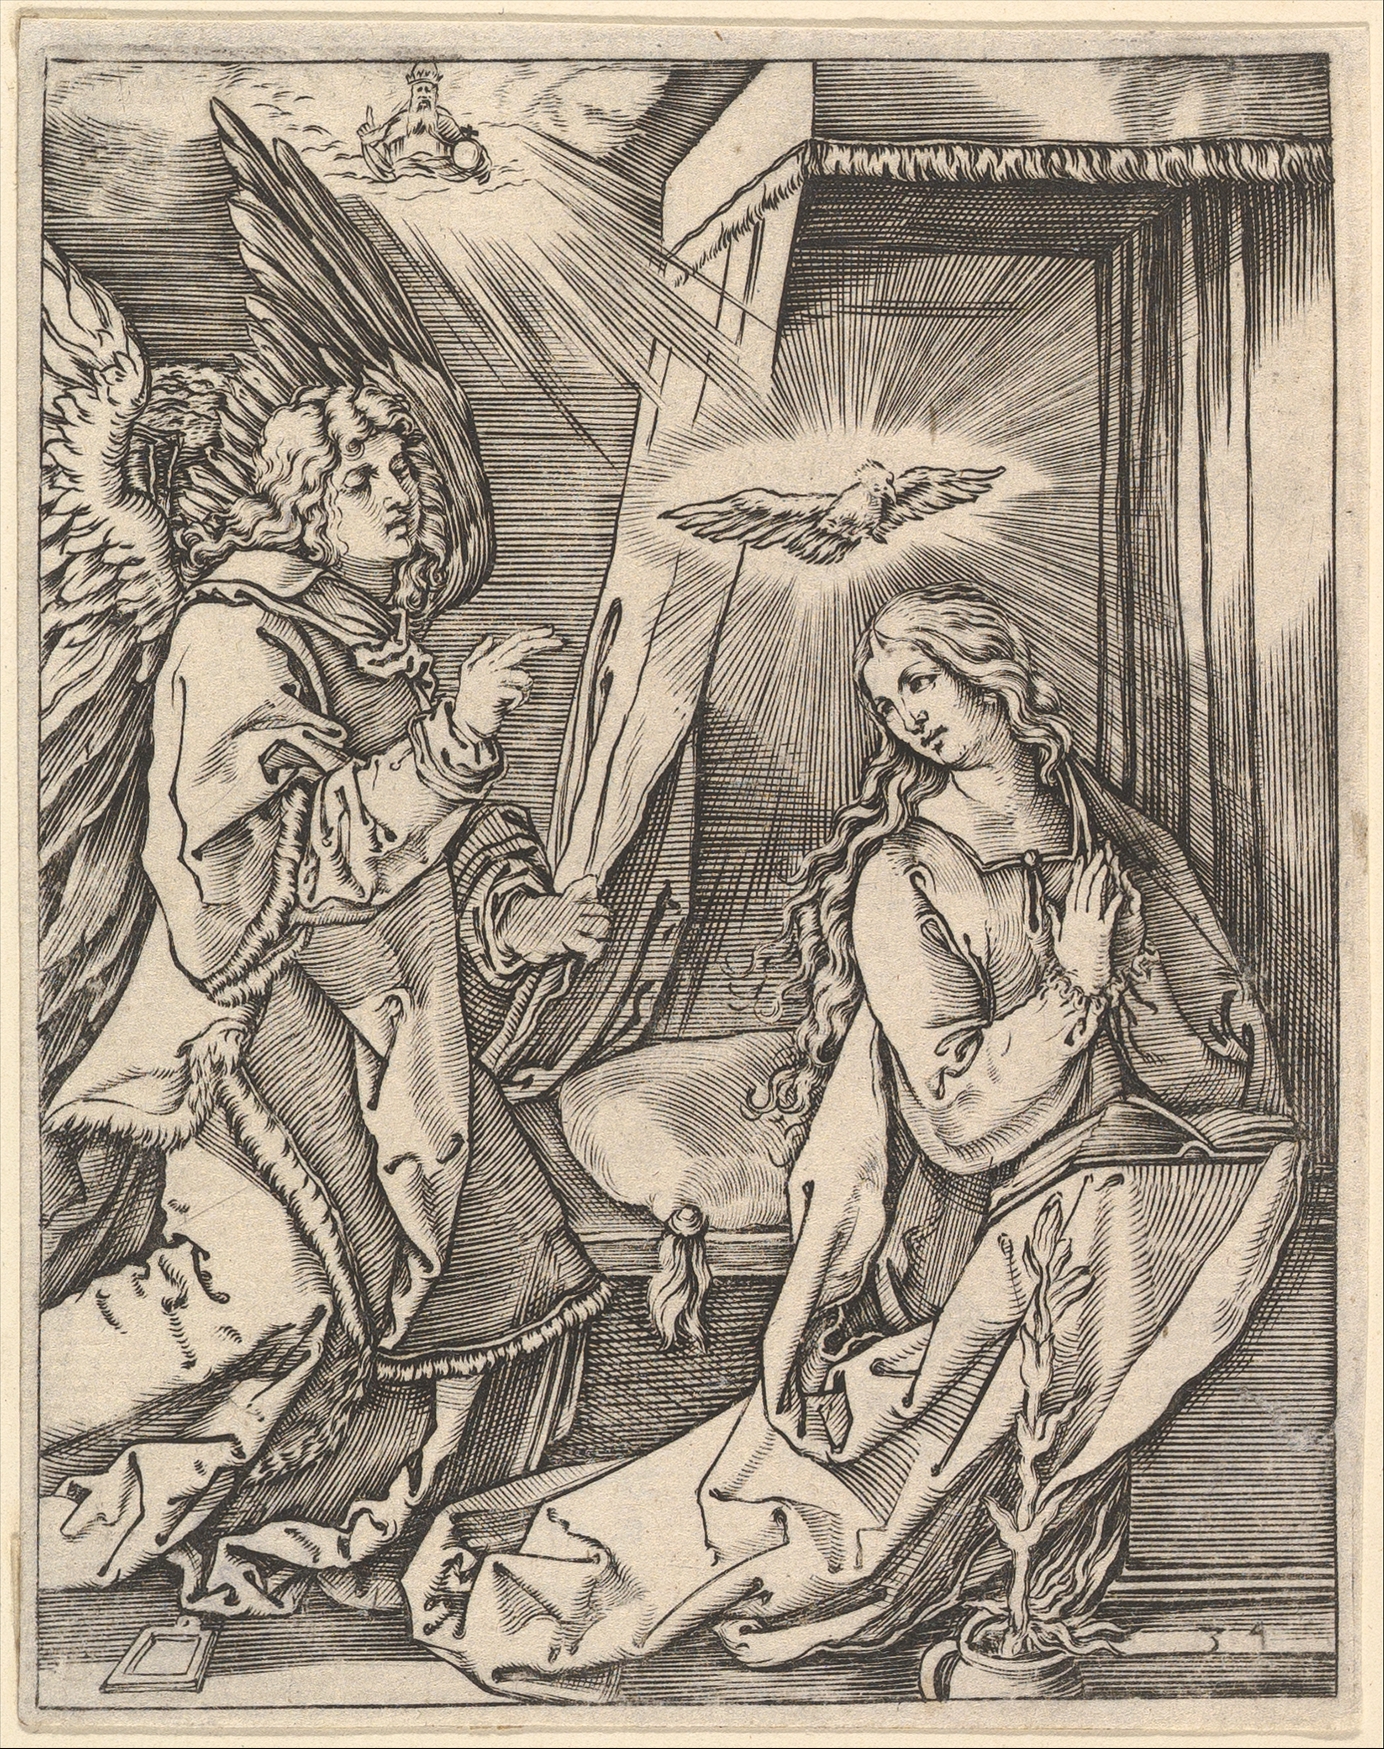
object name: print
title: The Annunciation; on the left the archangel Gabriel approaches the praying Virgin Mary in her bedchamber, over her head a dove representing the Holy Ghost, in the sky above a figure of God the Father, from "The Passion of Christ", after Dürer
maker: marcantonio raimondi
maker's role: artist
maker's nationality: italian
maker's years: 1475-1534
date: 1500-1534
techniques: engraving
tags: virgin mary,archangel gabriel,annunciation